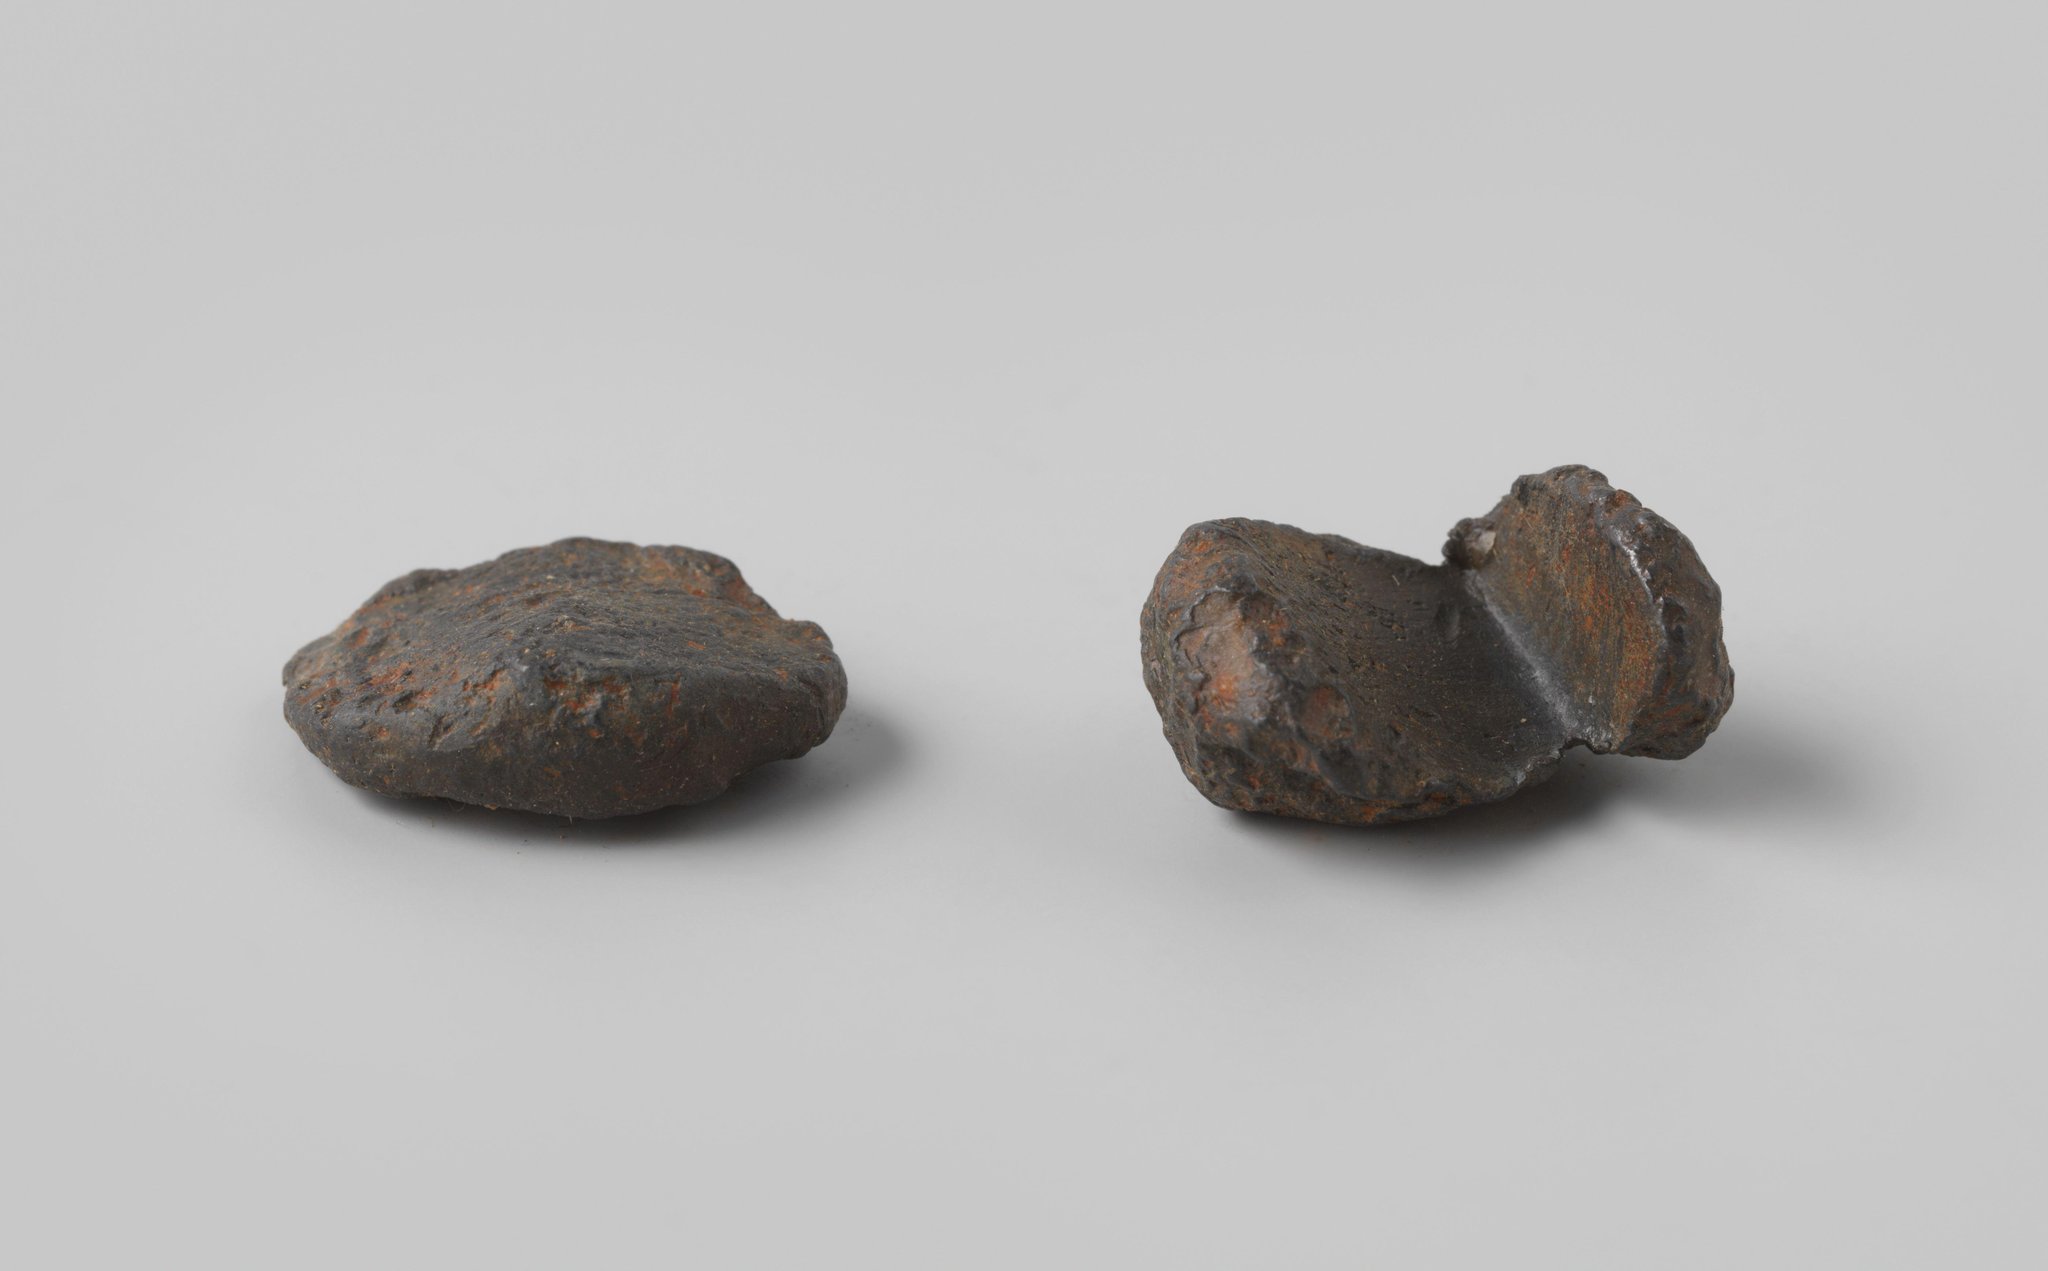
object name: musketkogel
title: Musketkogels uit het wrak van de Oost-Indiëvaarder Hollandia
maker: Anonymous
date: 1700-1743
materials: lead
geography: netherlands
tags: verenigde oostindische compagnie, hollandia (schip), annet